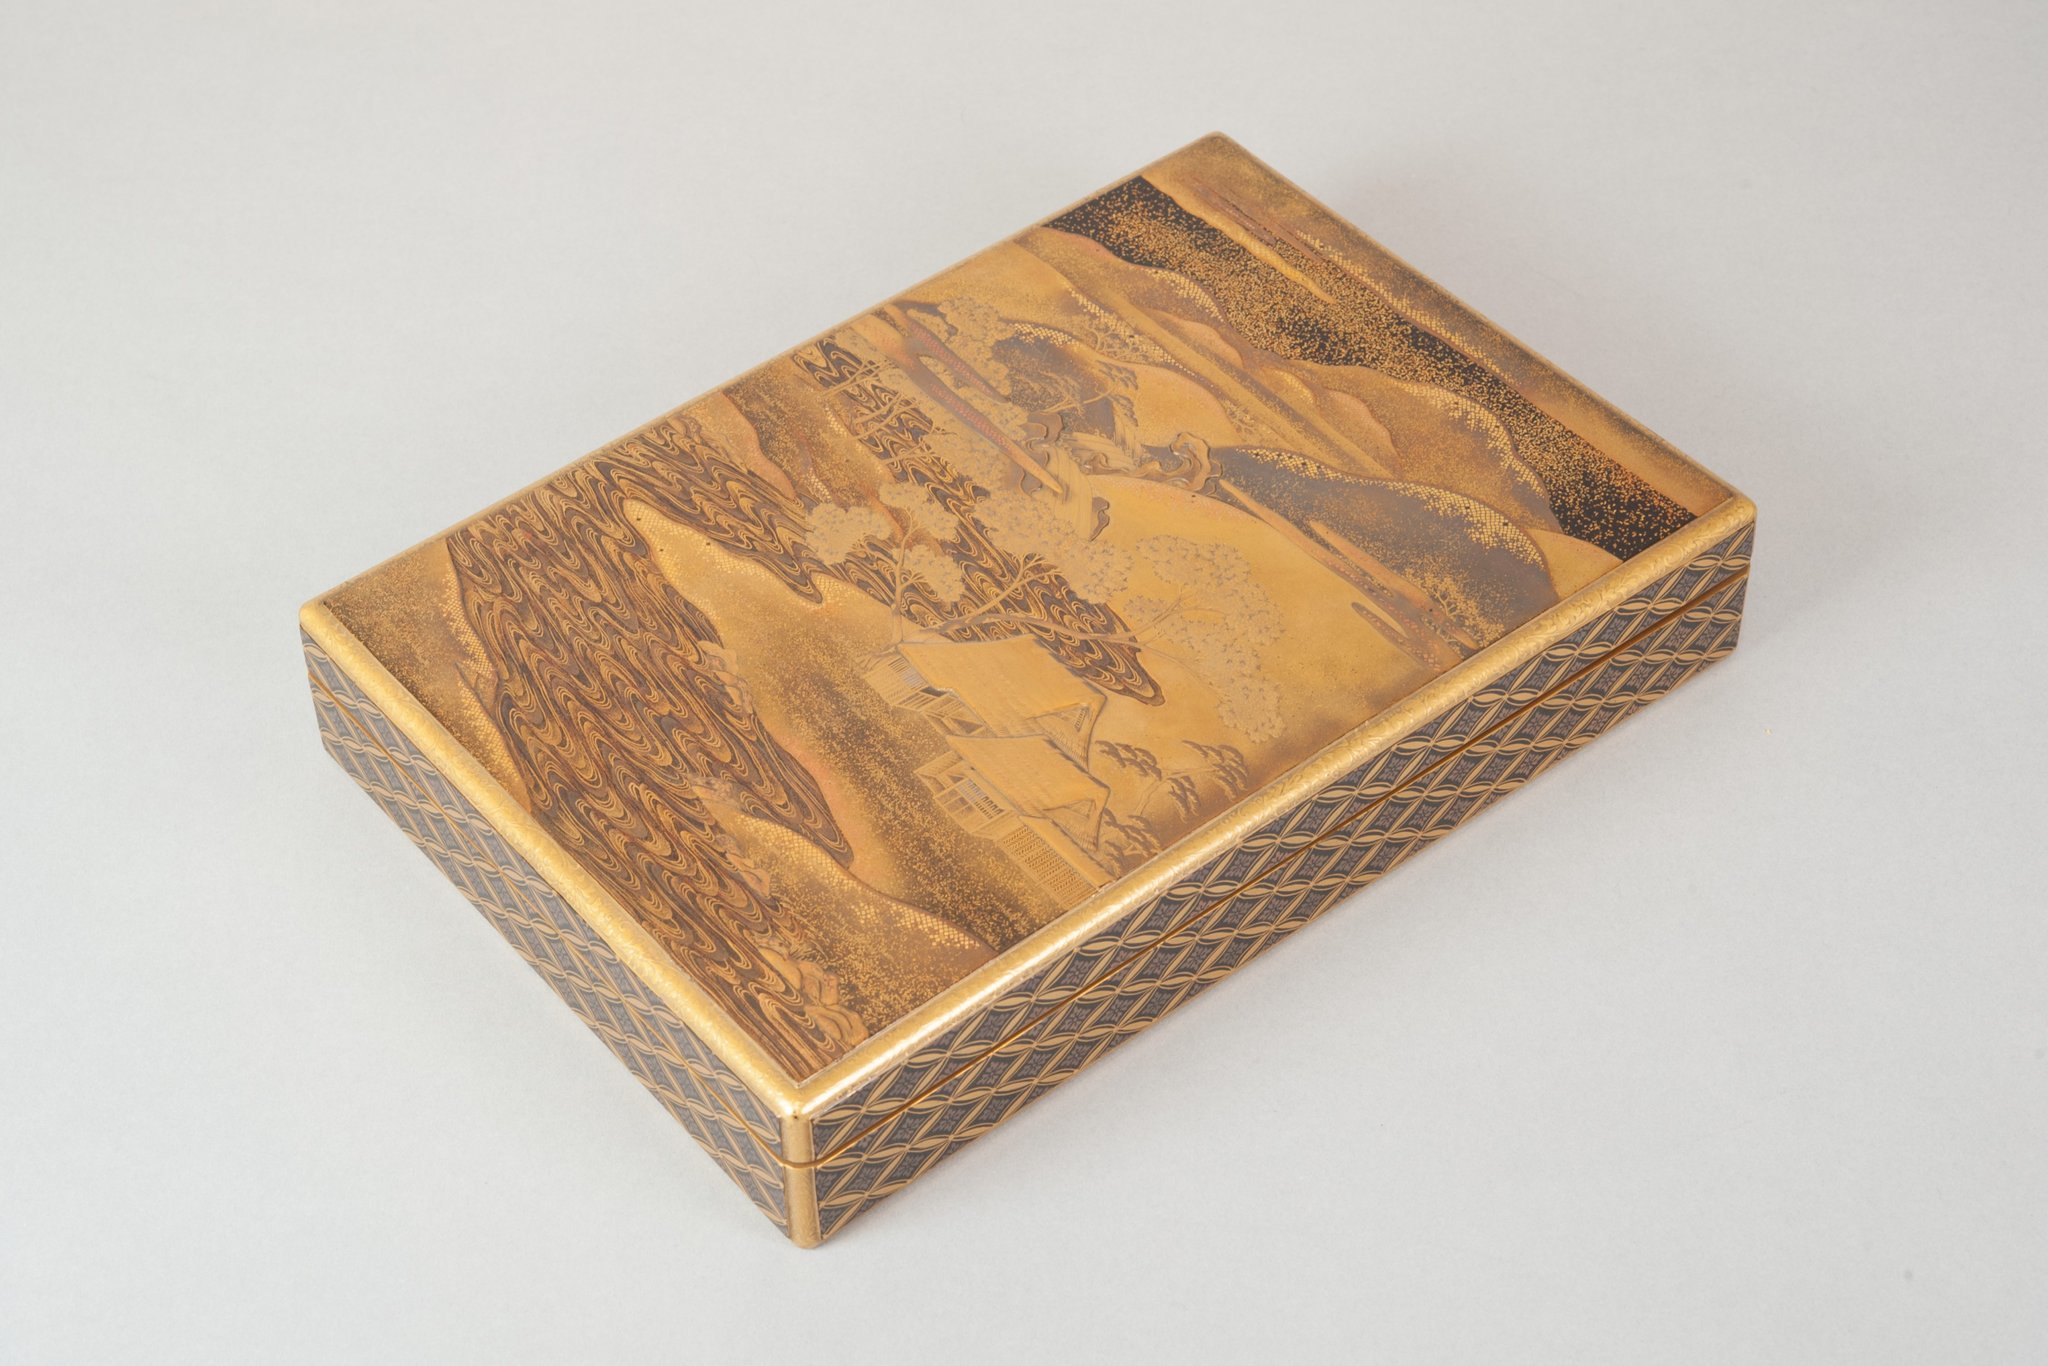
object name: document box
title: Document Box (Bunko) with Design of Cherry Trees in Bloom in Yoshino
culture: japanese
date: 1840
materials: gold, lacquer, silver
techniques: polish, relief, maki-e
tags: landscapes